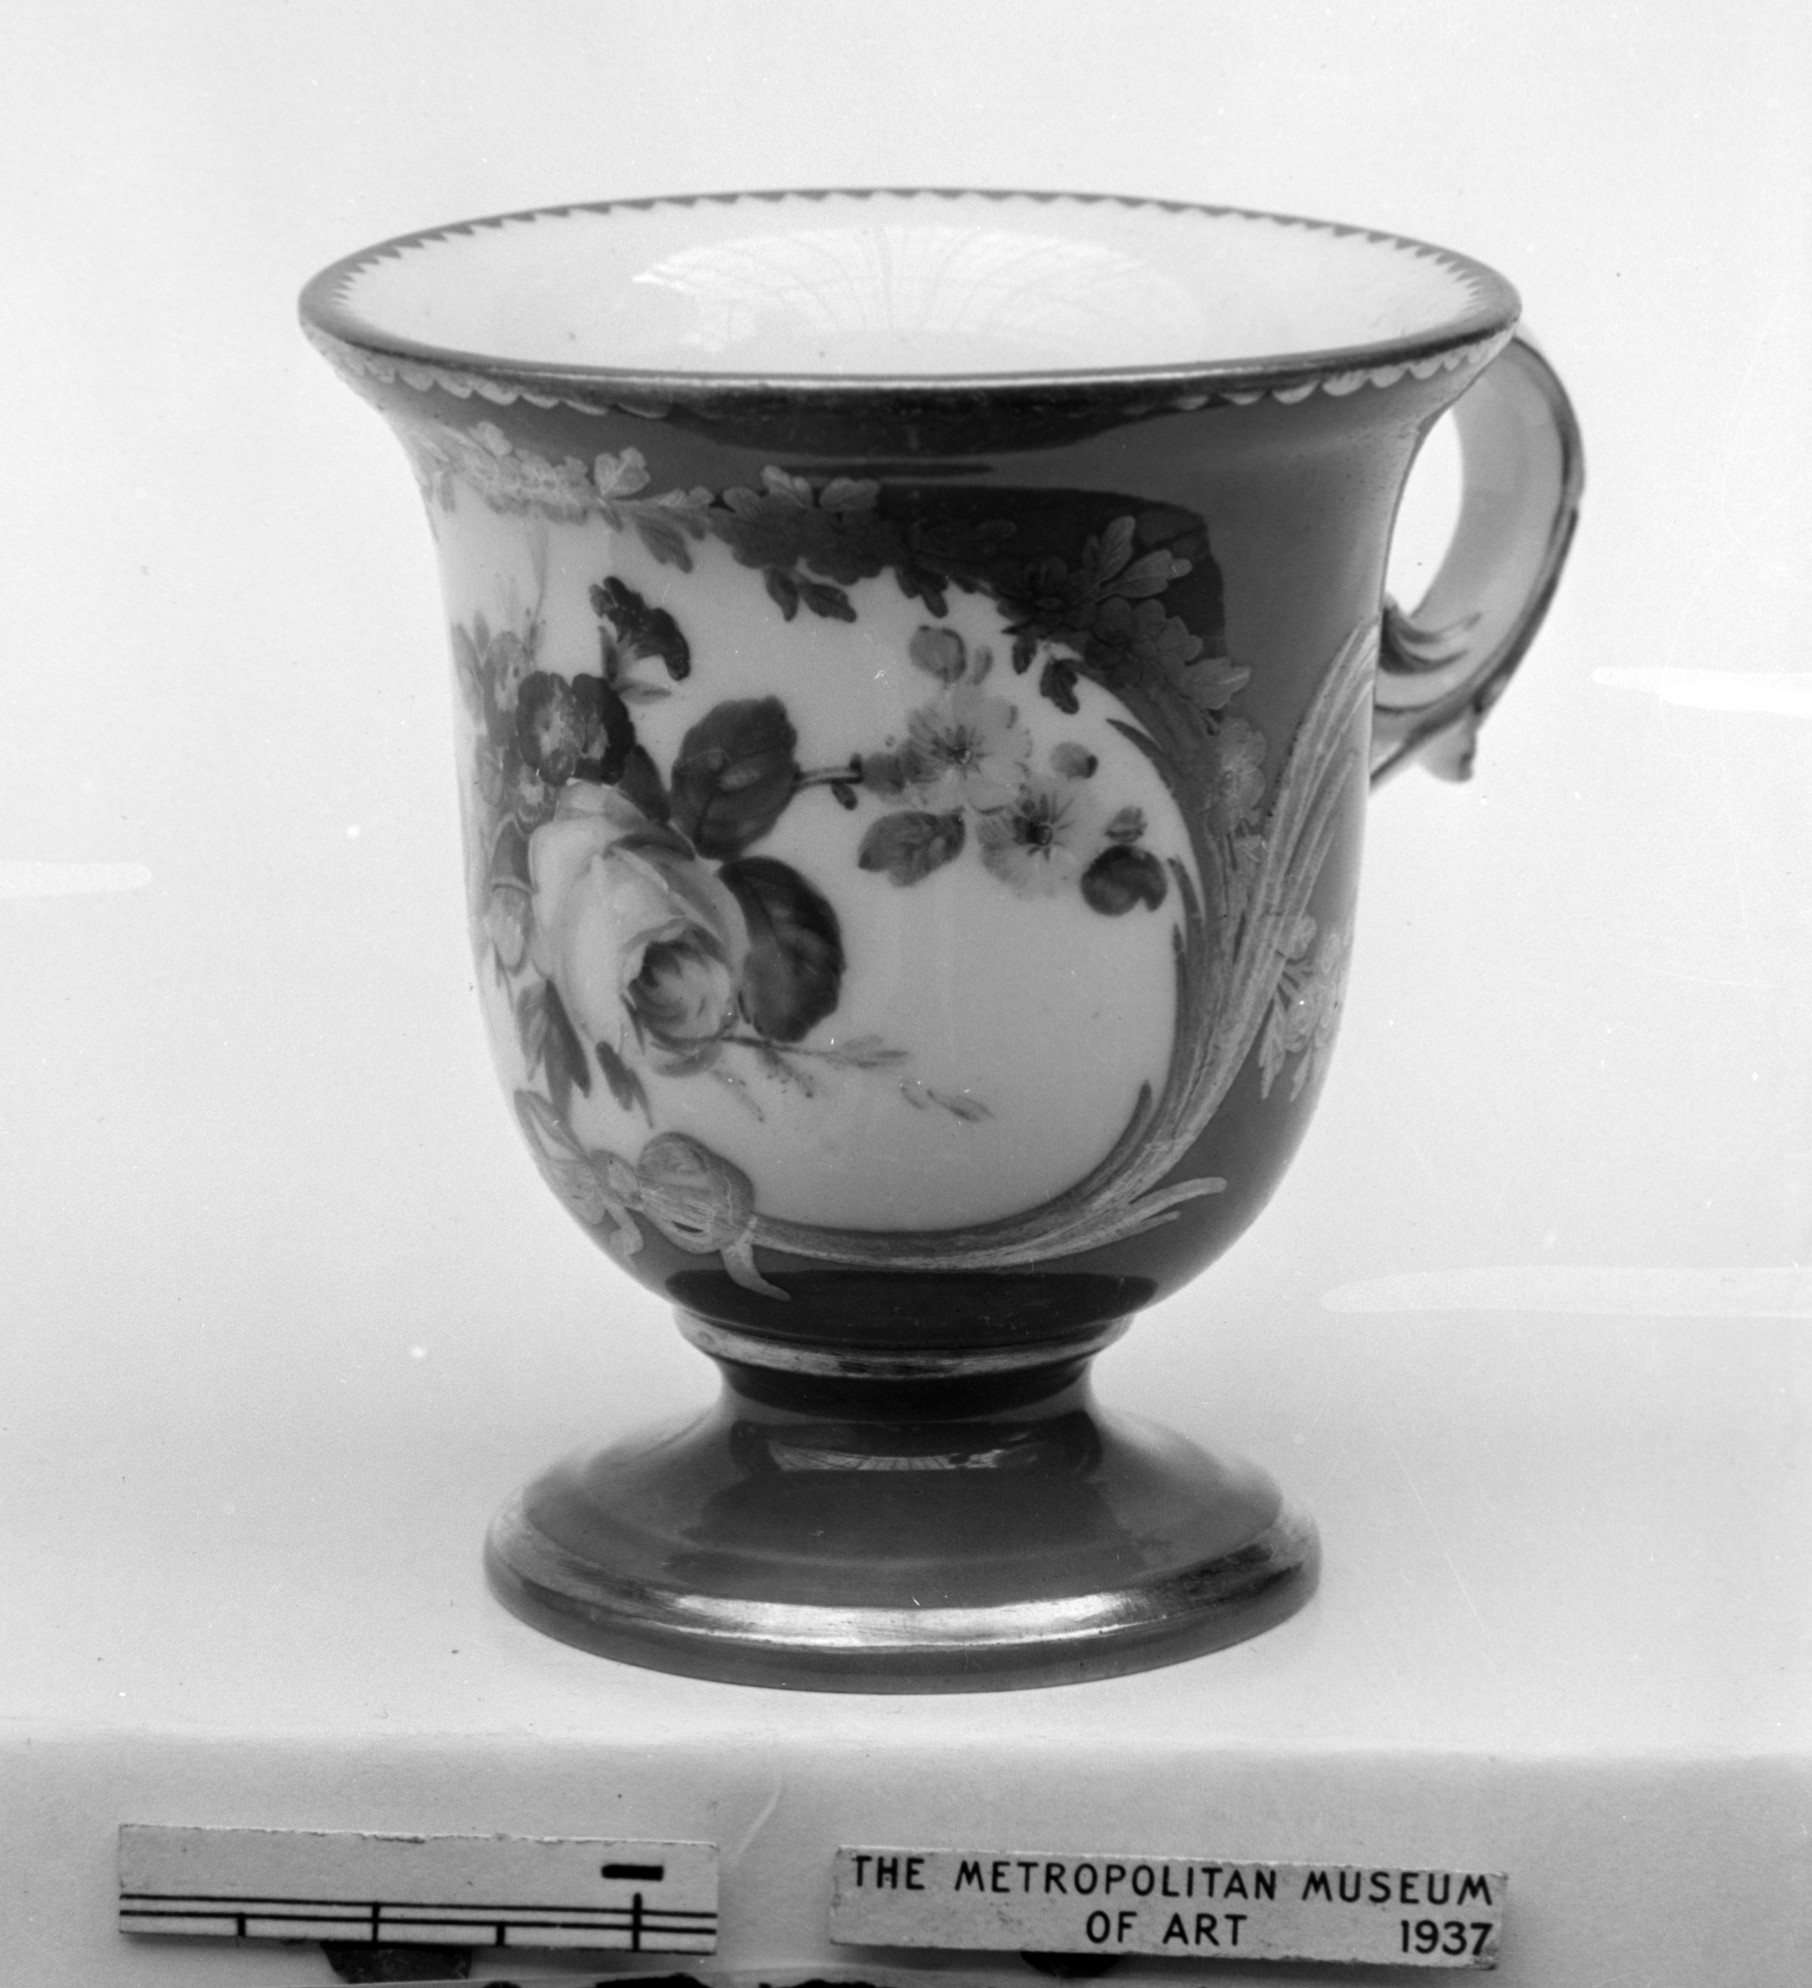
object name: ice cream cup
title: Ice cream cup (Tasse à glace) (part of a service)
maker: sèvres manufactory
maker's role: manufactory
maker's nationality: french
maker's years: 1740-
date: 1771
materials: soft paste porcelain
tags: flowers